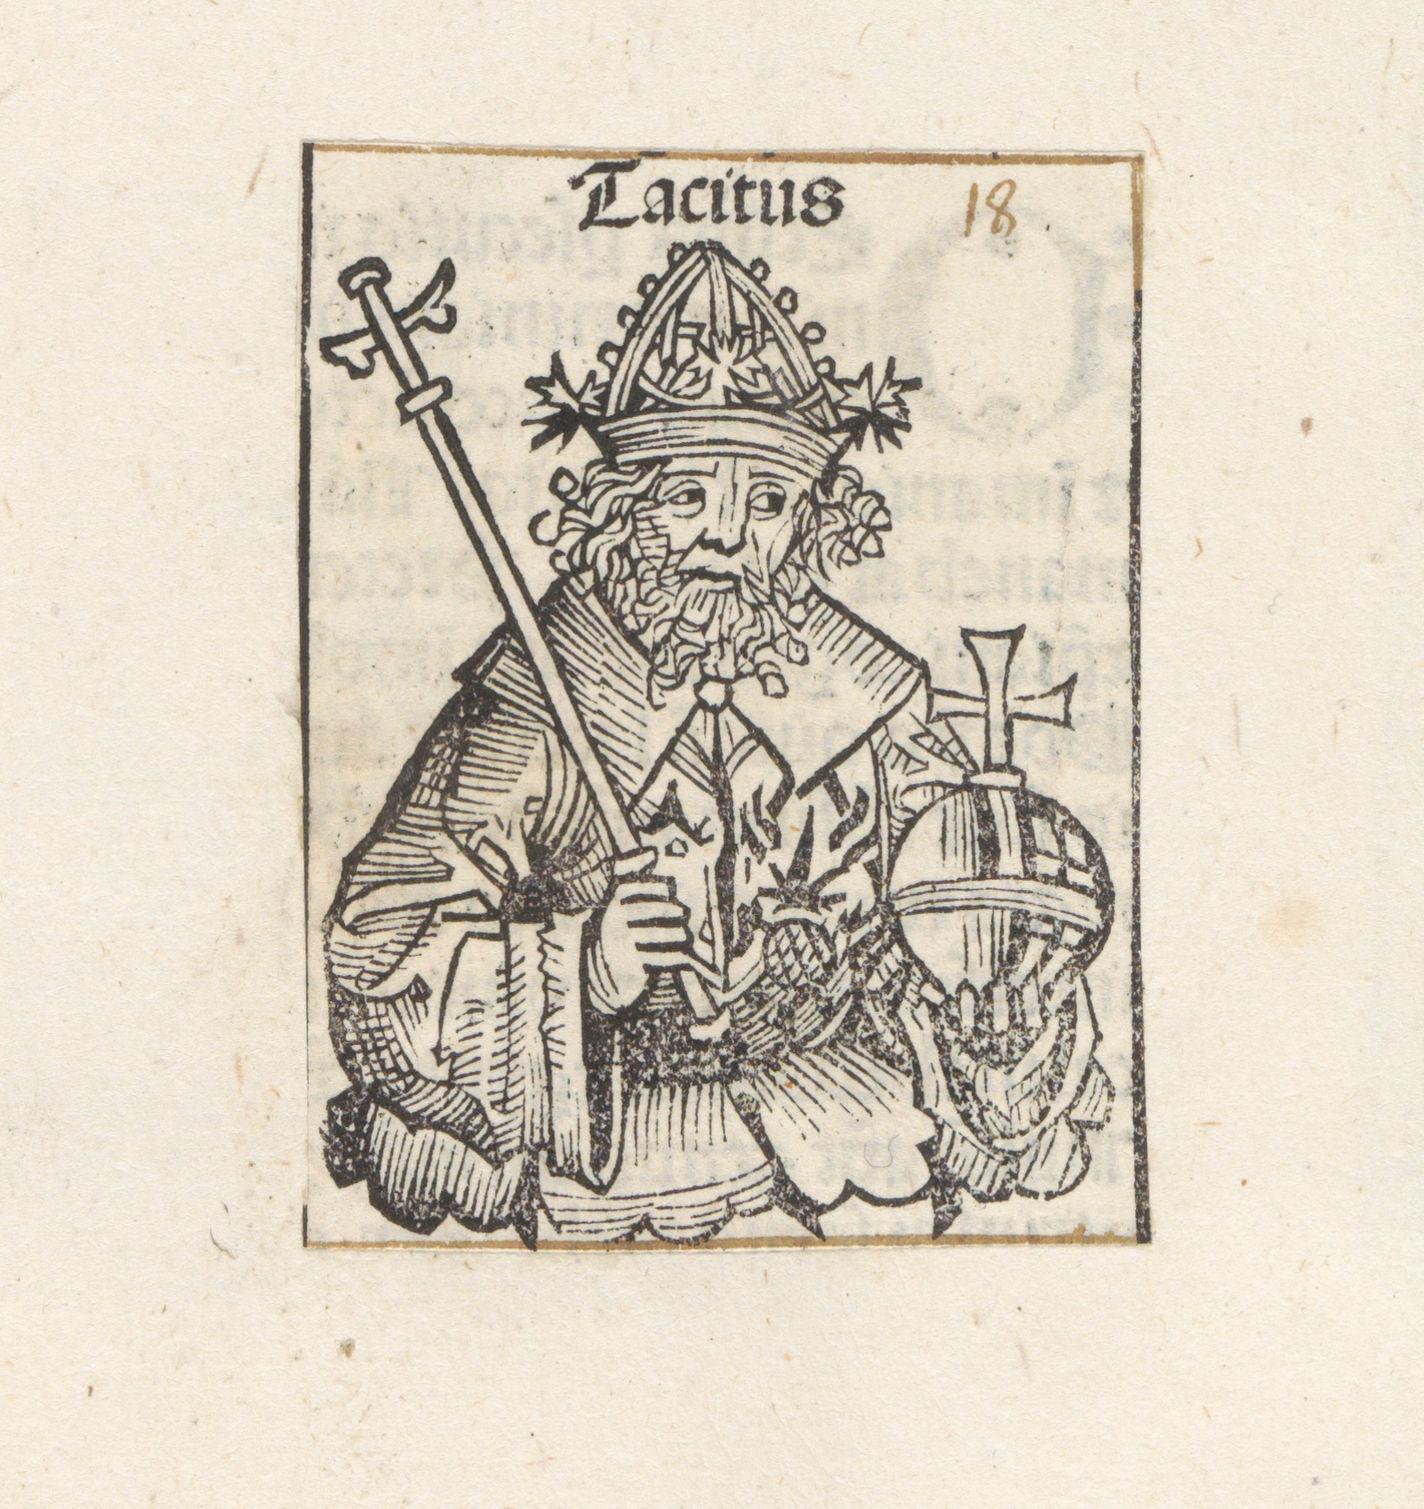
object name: print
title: Tacitus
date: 1493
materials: paper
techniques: letterpress printing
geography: nuremberg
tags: emperor, king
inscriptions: inscription: ‘18’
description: Een bloemkelk met een koning, naar rechts gekeerd. De man heeft een scepter en een rijksappel in zijn handen. De voorstelling is onderdeel van de opeenvolging Romeinse keizers in de Liber Chronicarum. De tekst identificeert de man als keizer Tacitus. De prent maakt deel uit van een album.